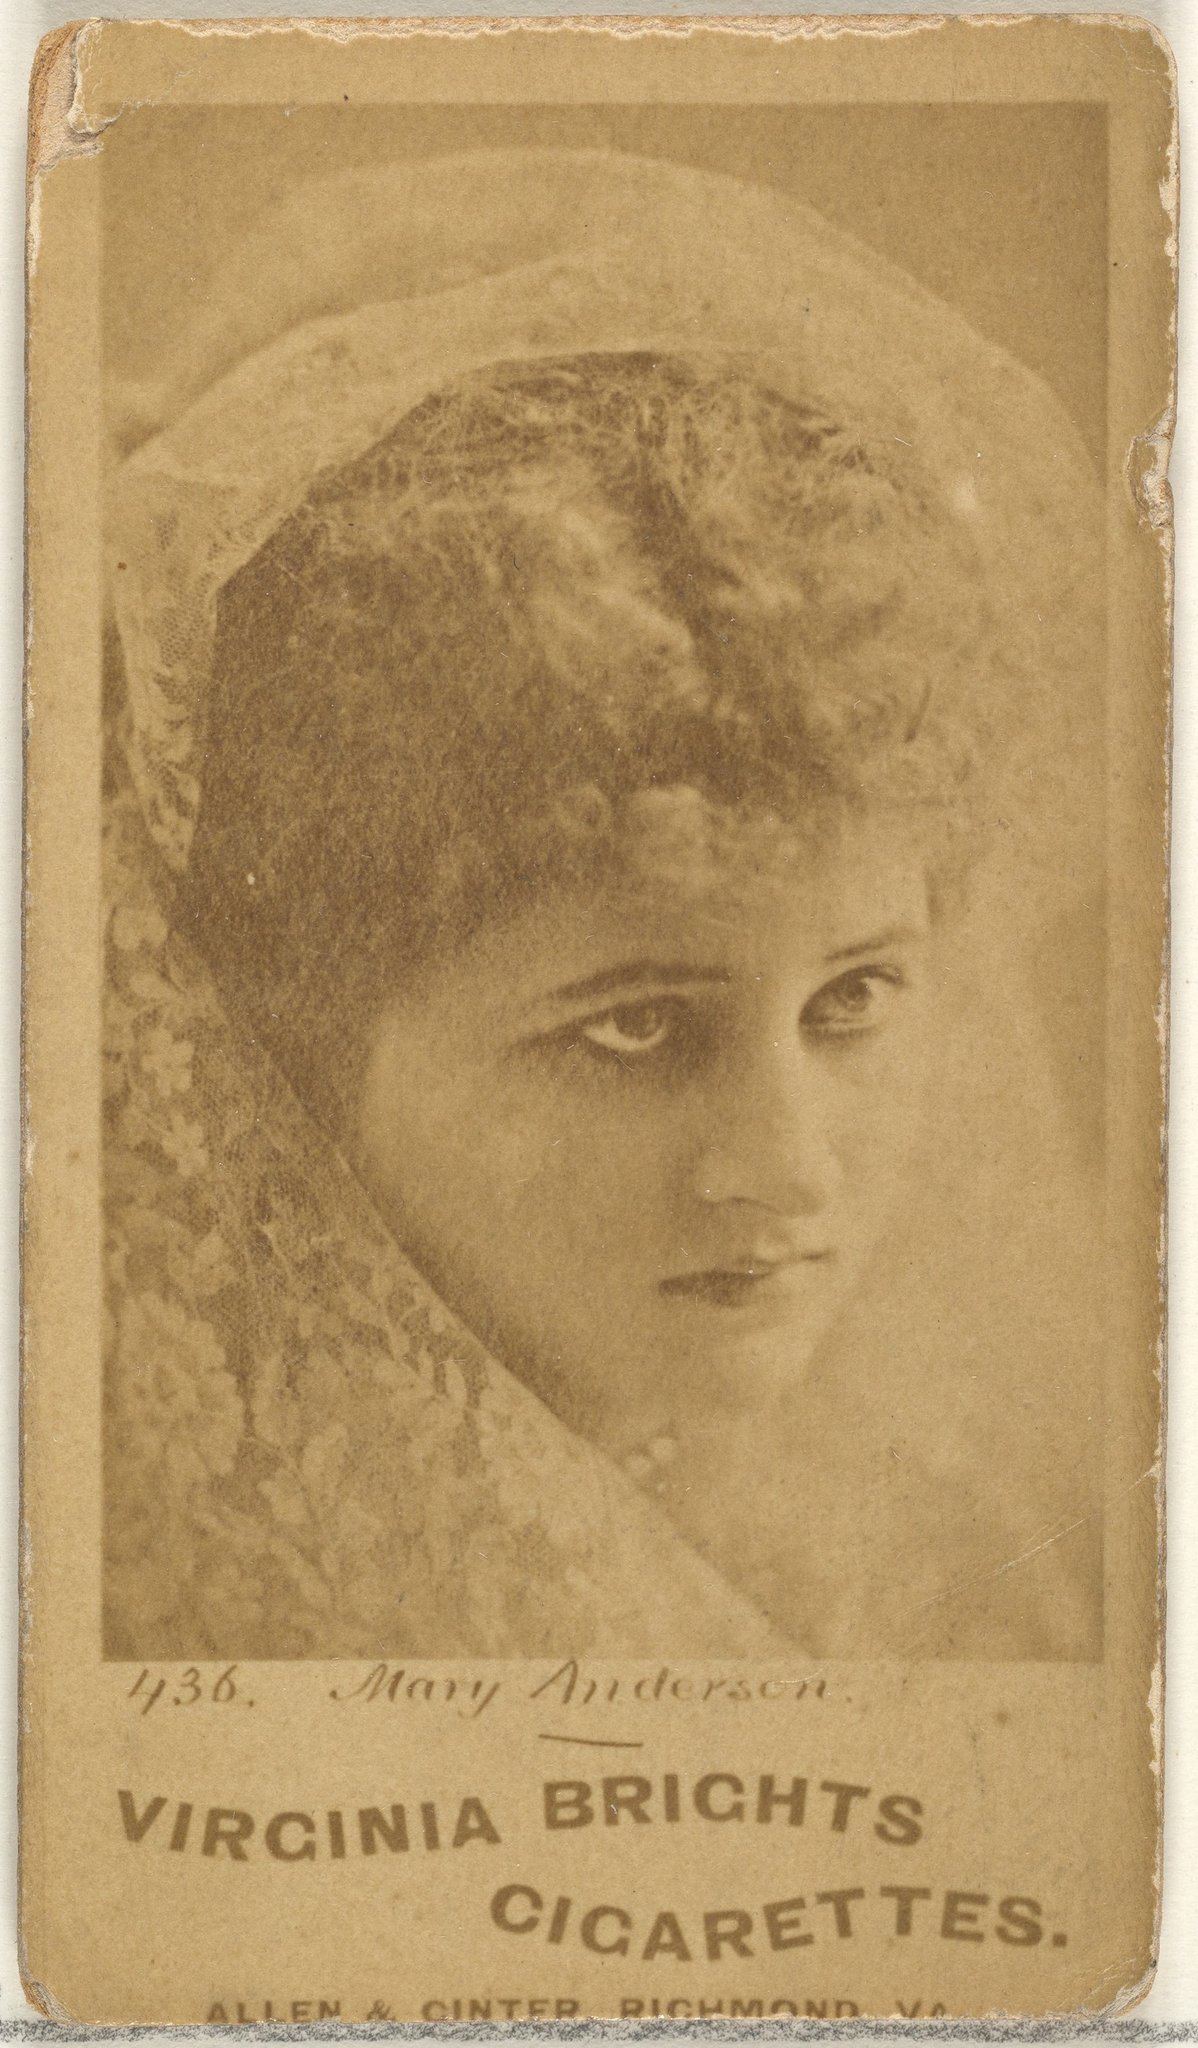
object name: photograph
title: Card 436, Mary Anderson, from the Actors and Actresses series (N45, Type 1) for Virginia Brights Cigarettes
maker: allen & ginter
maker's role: publisher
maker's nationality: american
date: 1888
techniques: albumen silver print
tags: portraits,women,actresses